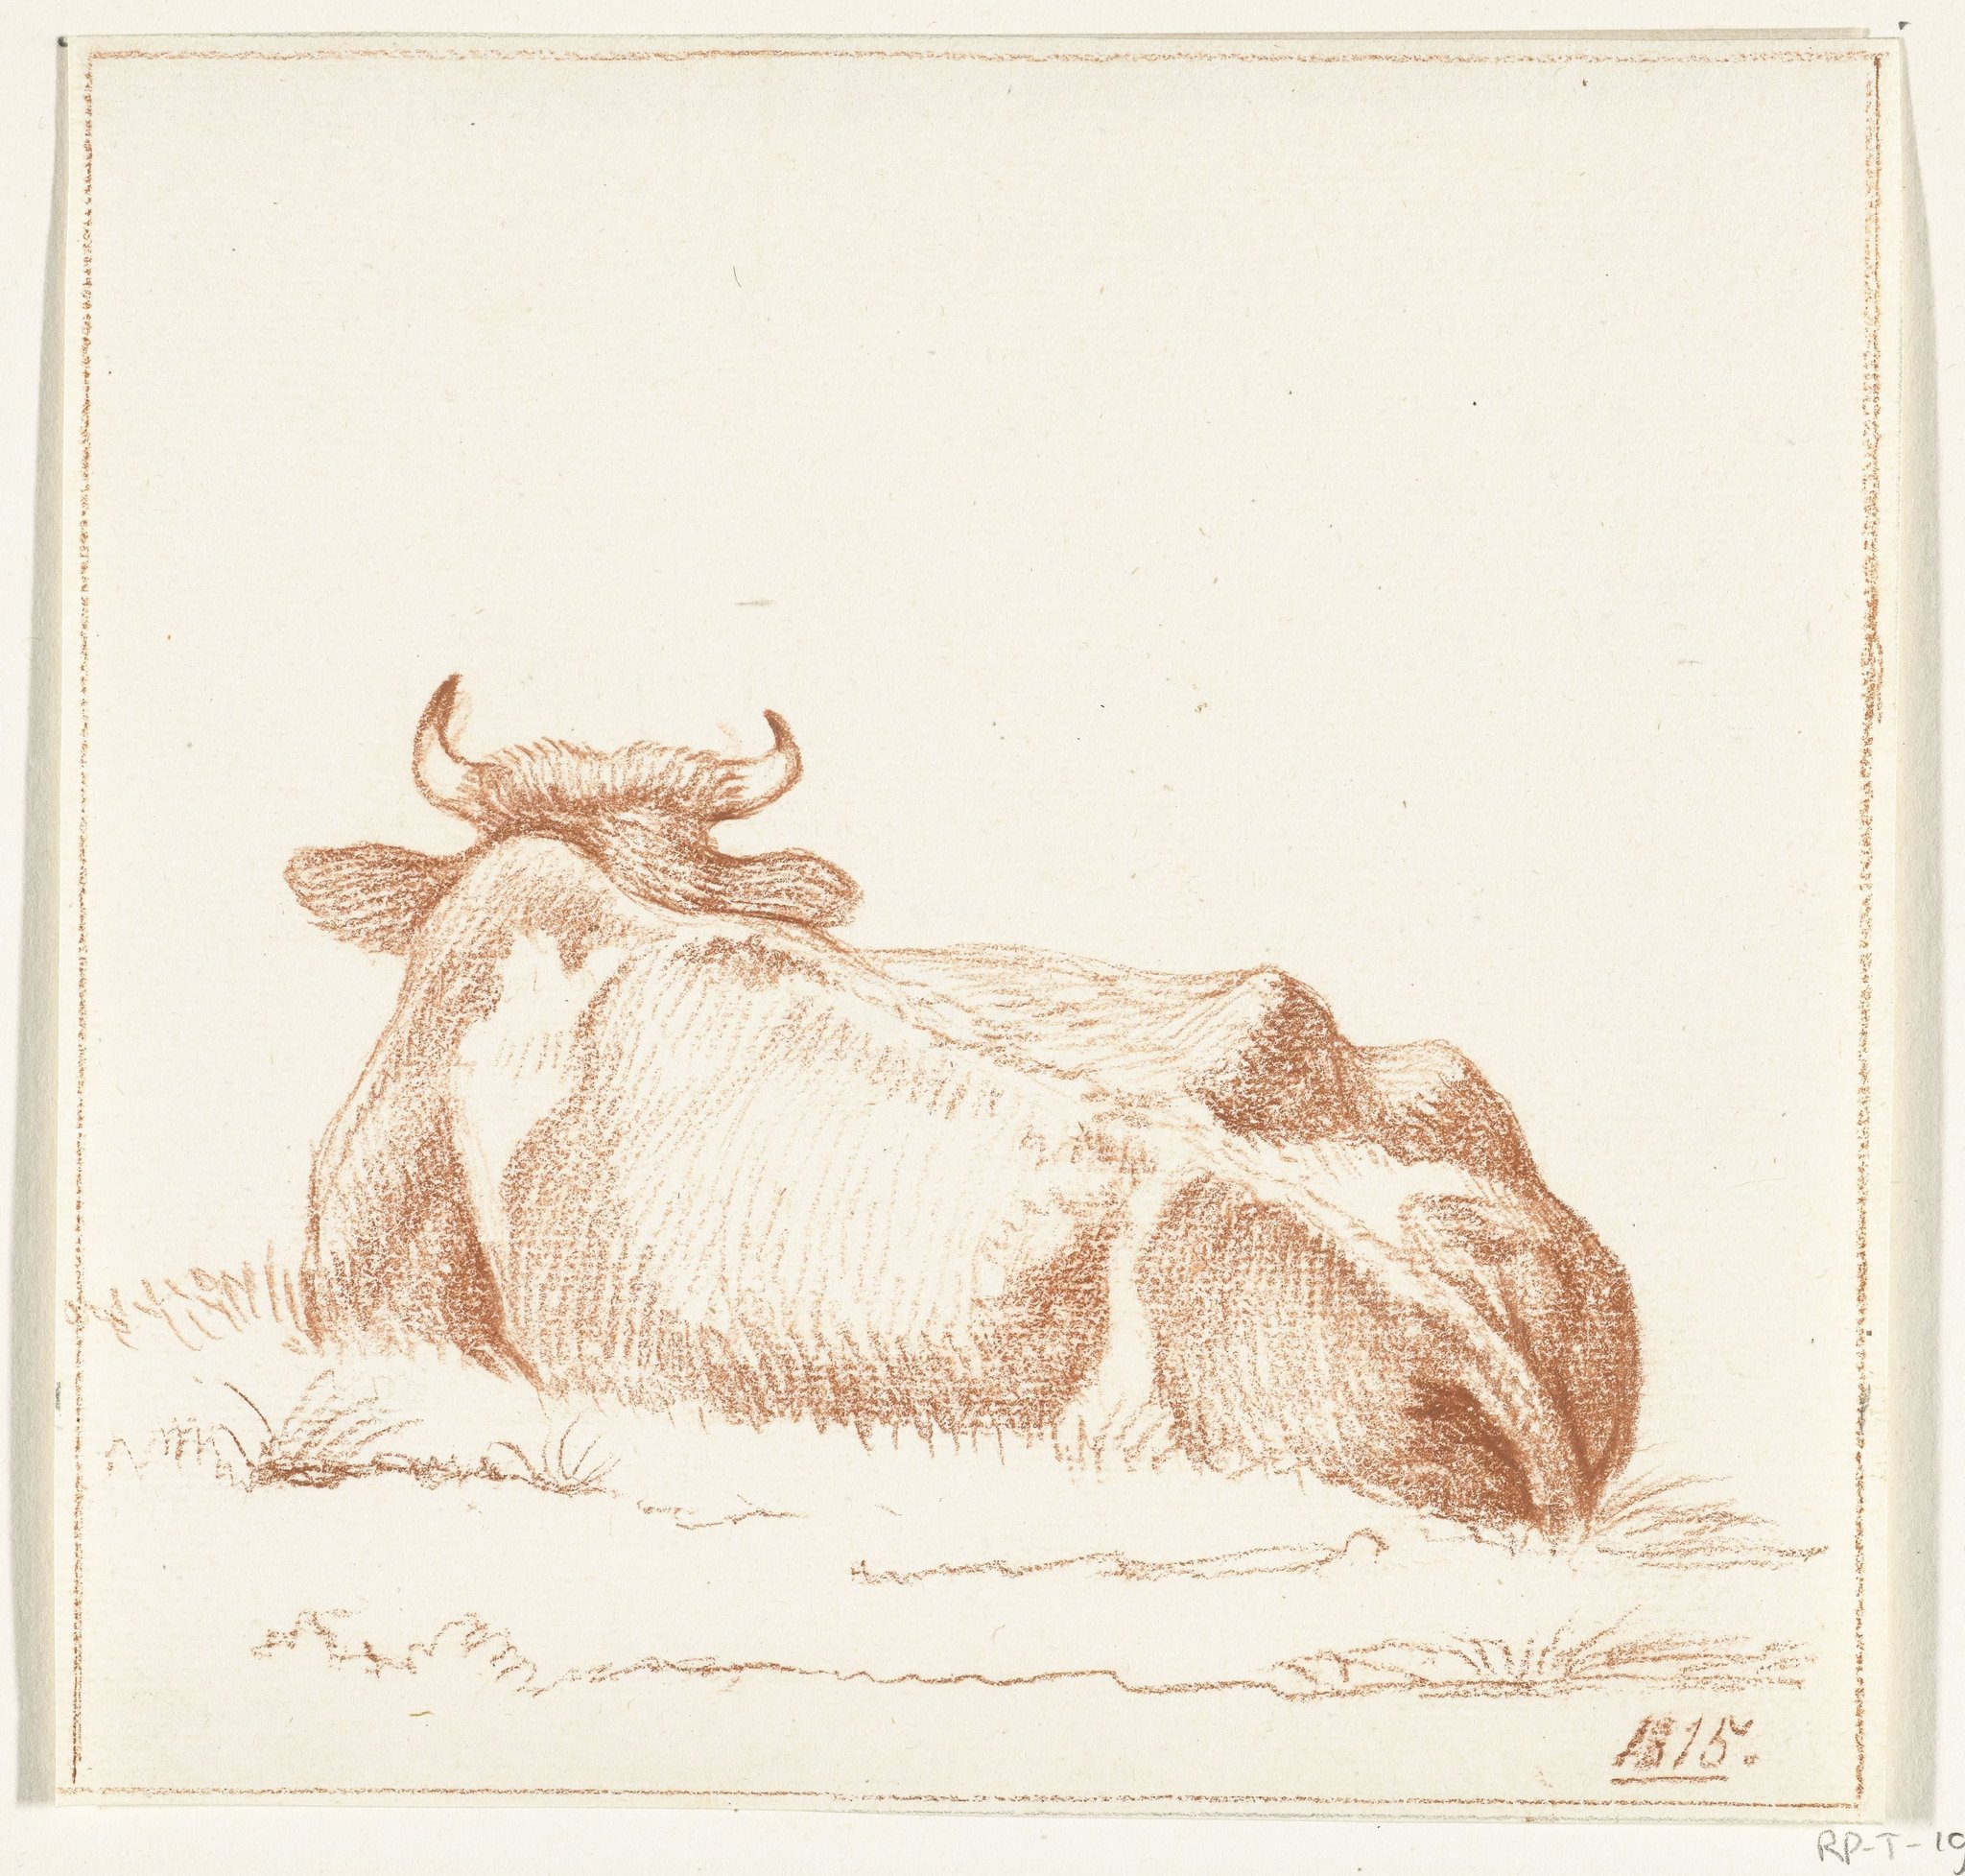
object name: drawing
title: Liggende koe, van achteren gezien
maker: jean bernard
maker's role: draughtsman, print maker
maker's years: 1765-1833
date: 1815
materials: chalk, paper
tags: cow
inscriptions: date: ‘1815’